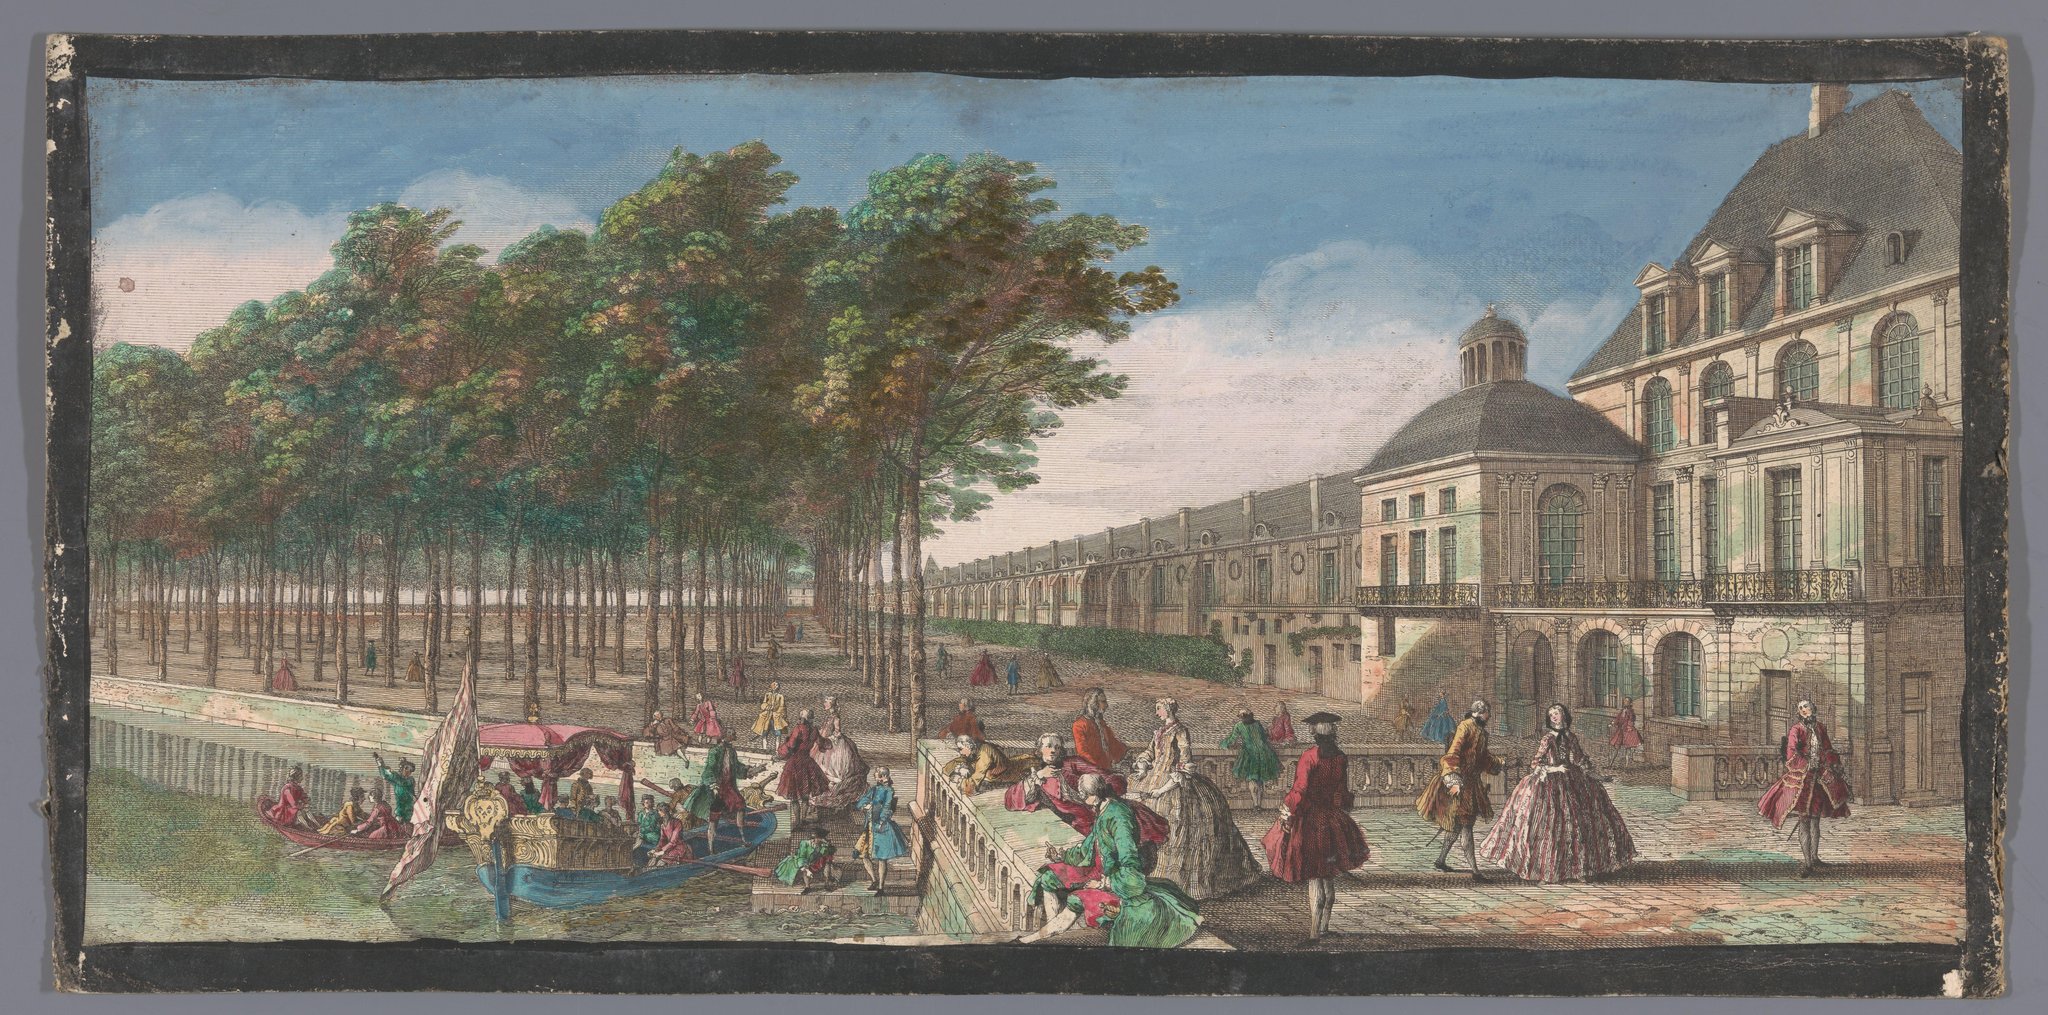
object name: opticaprent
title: Gezicht op de Cour de la Fontaine van het Palais de Fontainebleau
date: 1700-1799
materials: cardboard, paper, watercolor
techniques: brush, etching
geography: paris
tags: palace, rowing-boat, canoe, etc., inner court of palace or 'hôtel'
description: Links vaart een overdekte roeiboot met een aantal figuren op het water.